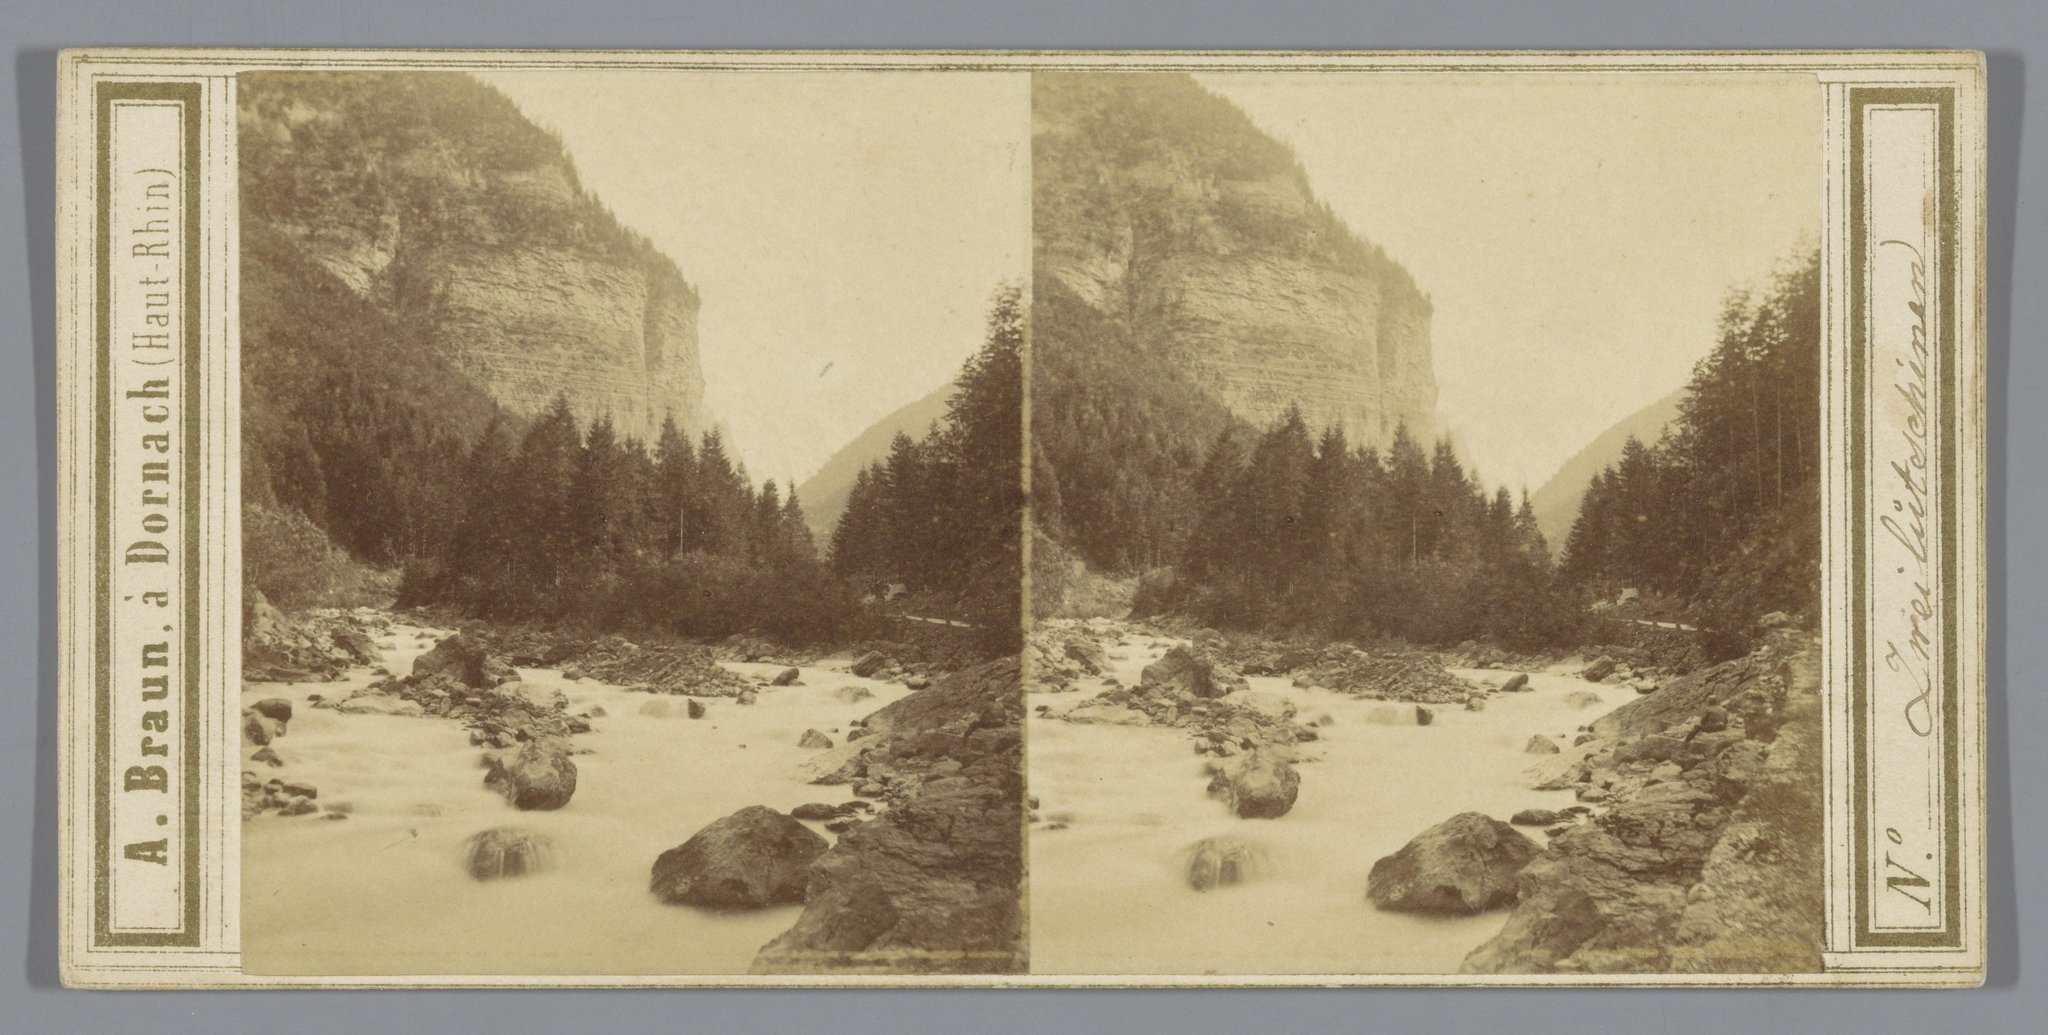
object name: stereograph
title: Zweilütschinen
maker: Anonymous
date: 1860-1866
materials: cardboard, paper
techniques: albumen print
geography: dornach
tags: rapids, mountain meadow, alp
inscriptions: number: ‘754.’, inscription: ‘Juli 1867. - Aug- 1885. - Sept 1893. - Aug- 1895’, number: ‘110’, inscription: ‘10c’